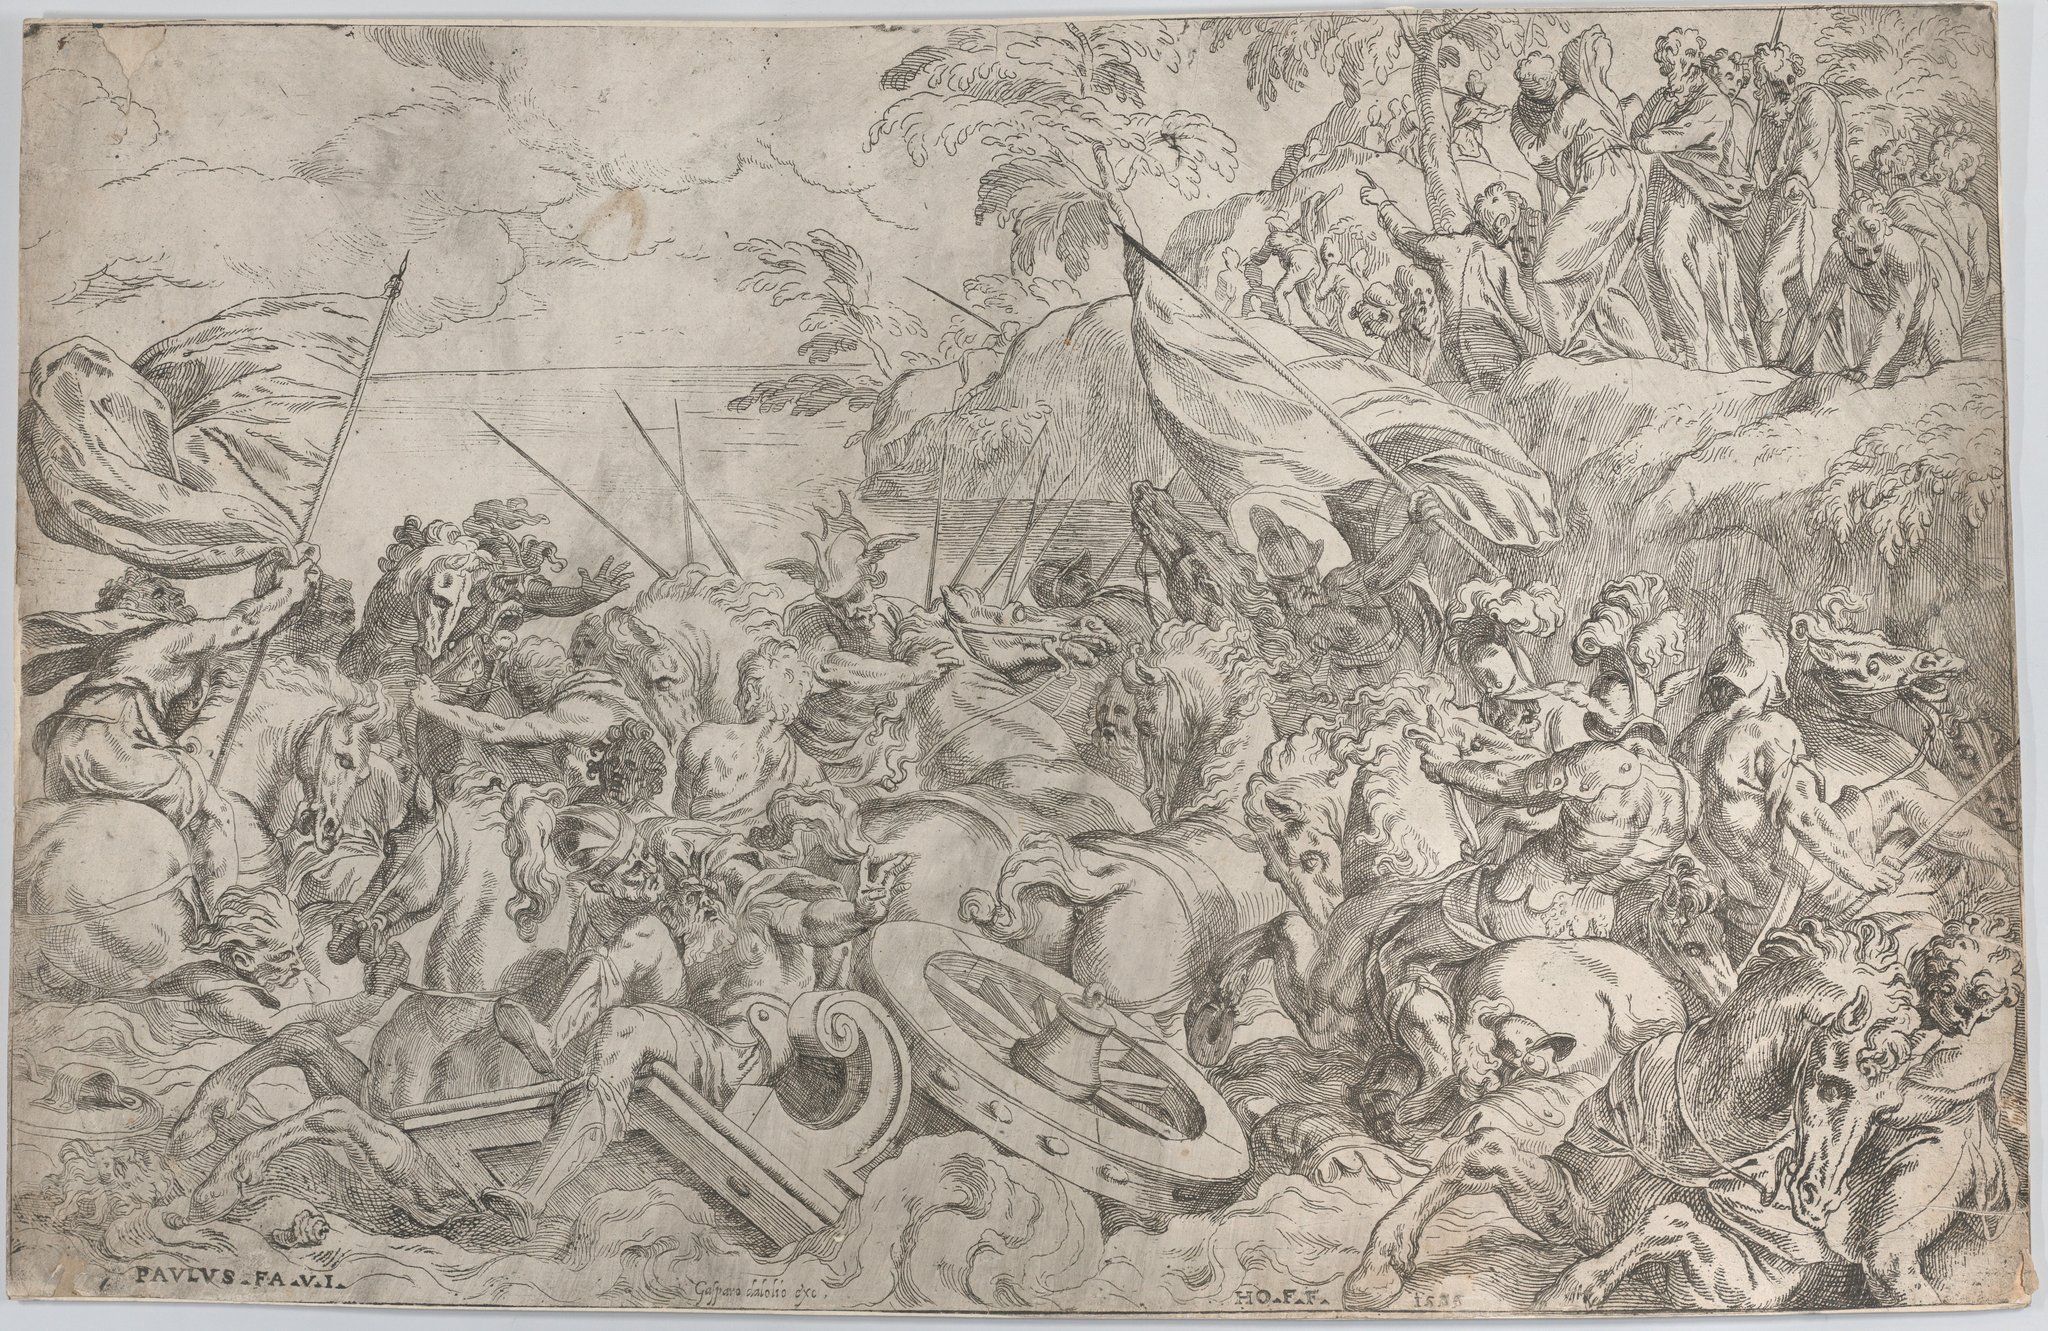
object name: print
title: The Crossing of the Red Sea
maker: orazio farinati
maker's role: artist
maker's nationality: italian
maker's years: 1559-1616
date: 1583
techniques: etching